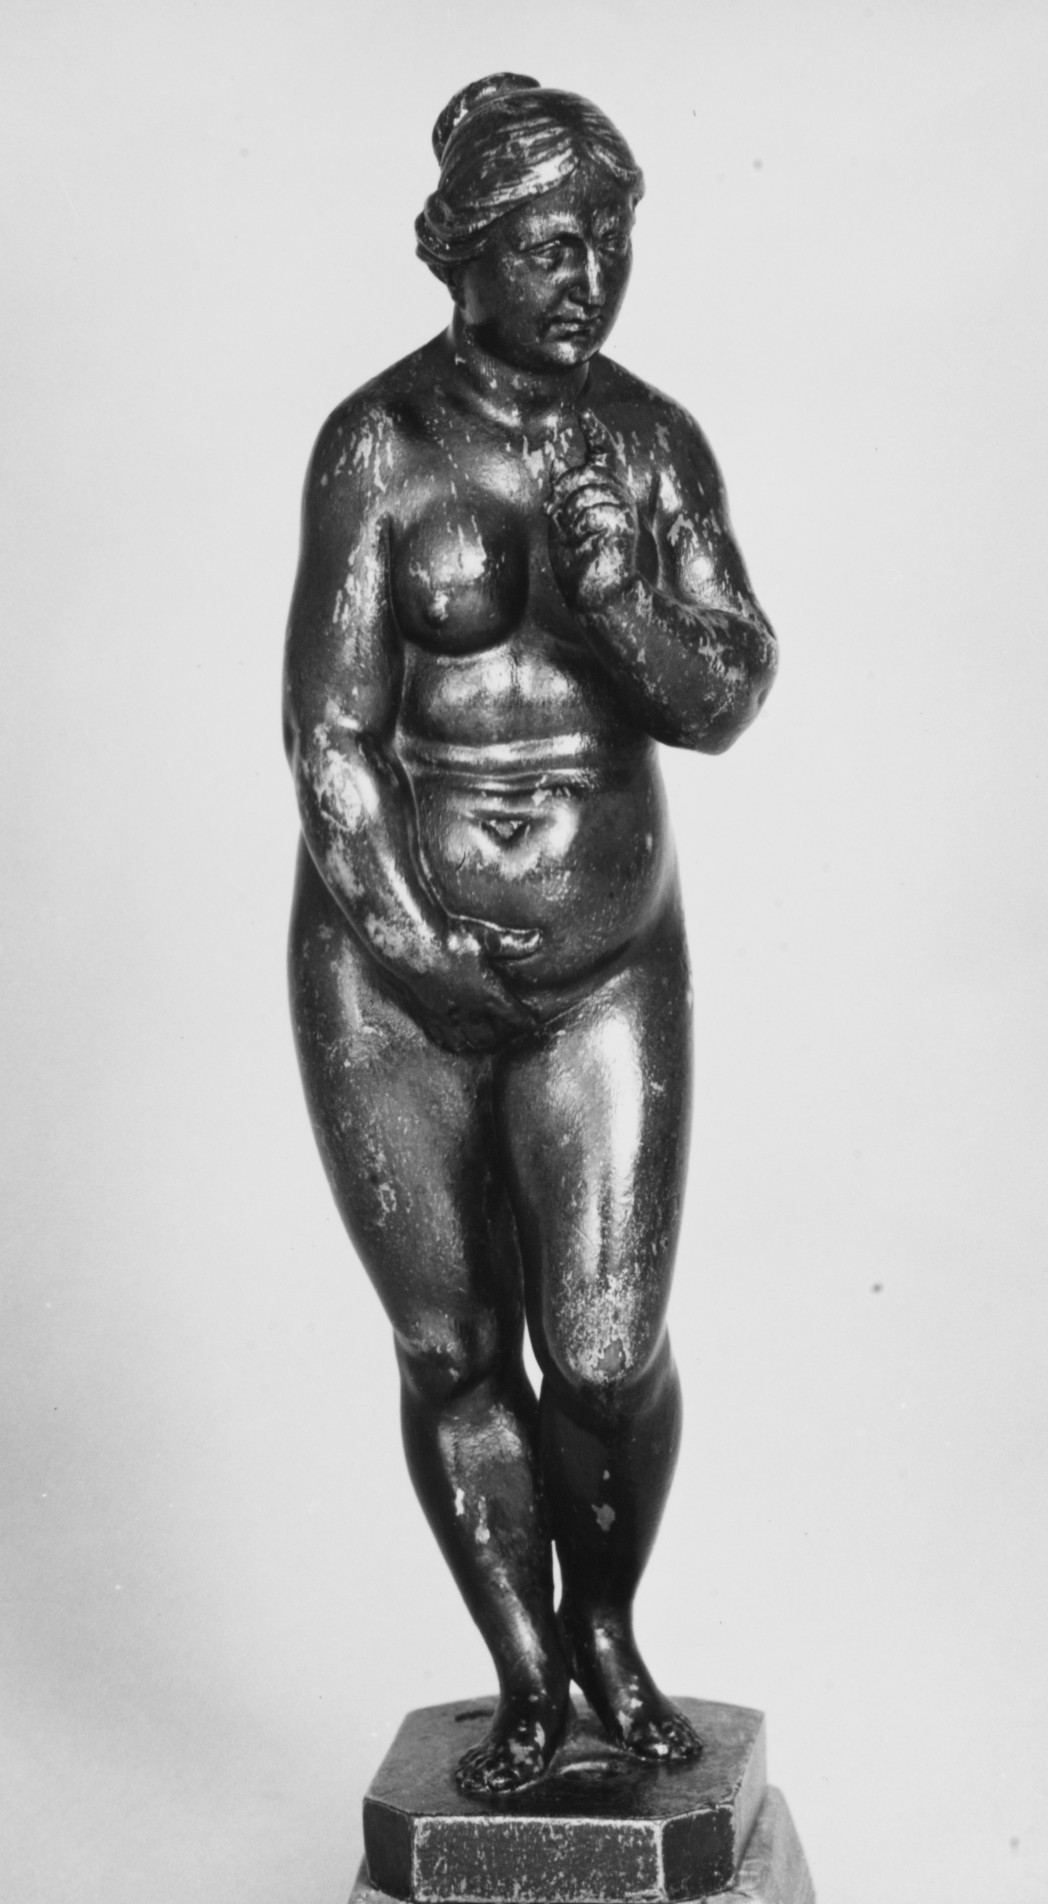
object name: statuette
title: Female statuette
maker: leonhard kern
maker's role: artist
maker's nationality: german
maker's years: 1588-1662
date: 1601-1700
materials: wood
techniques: painting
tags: female nudes